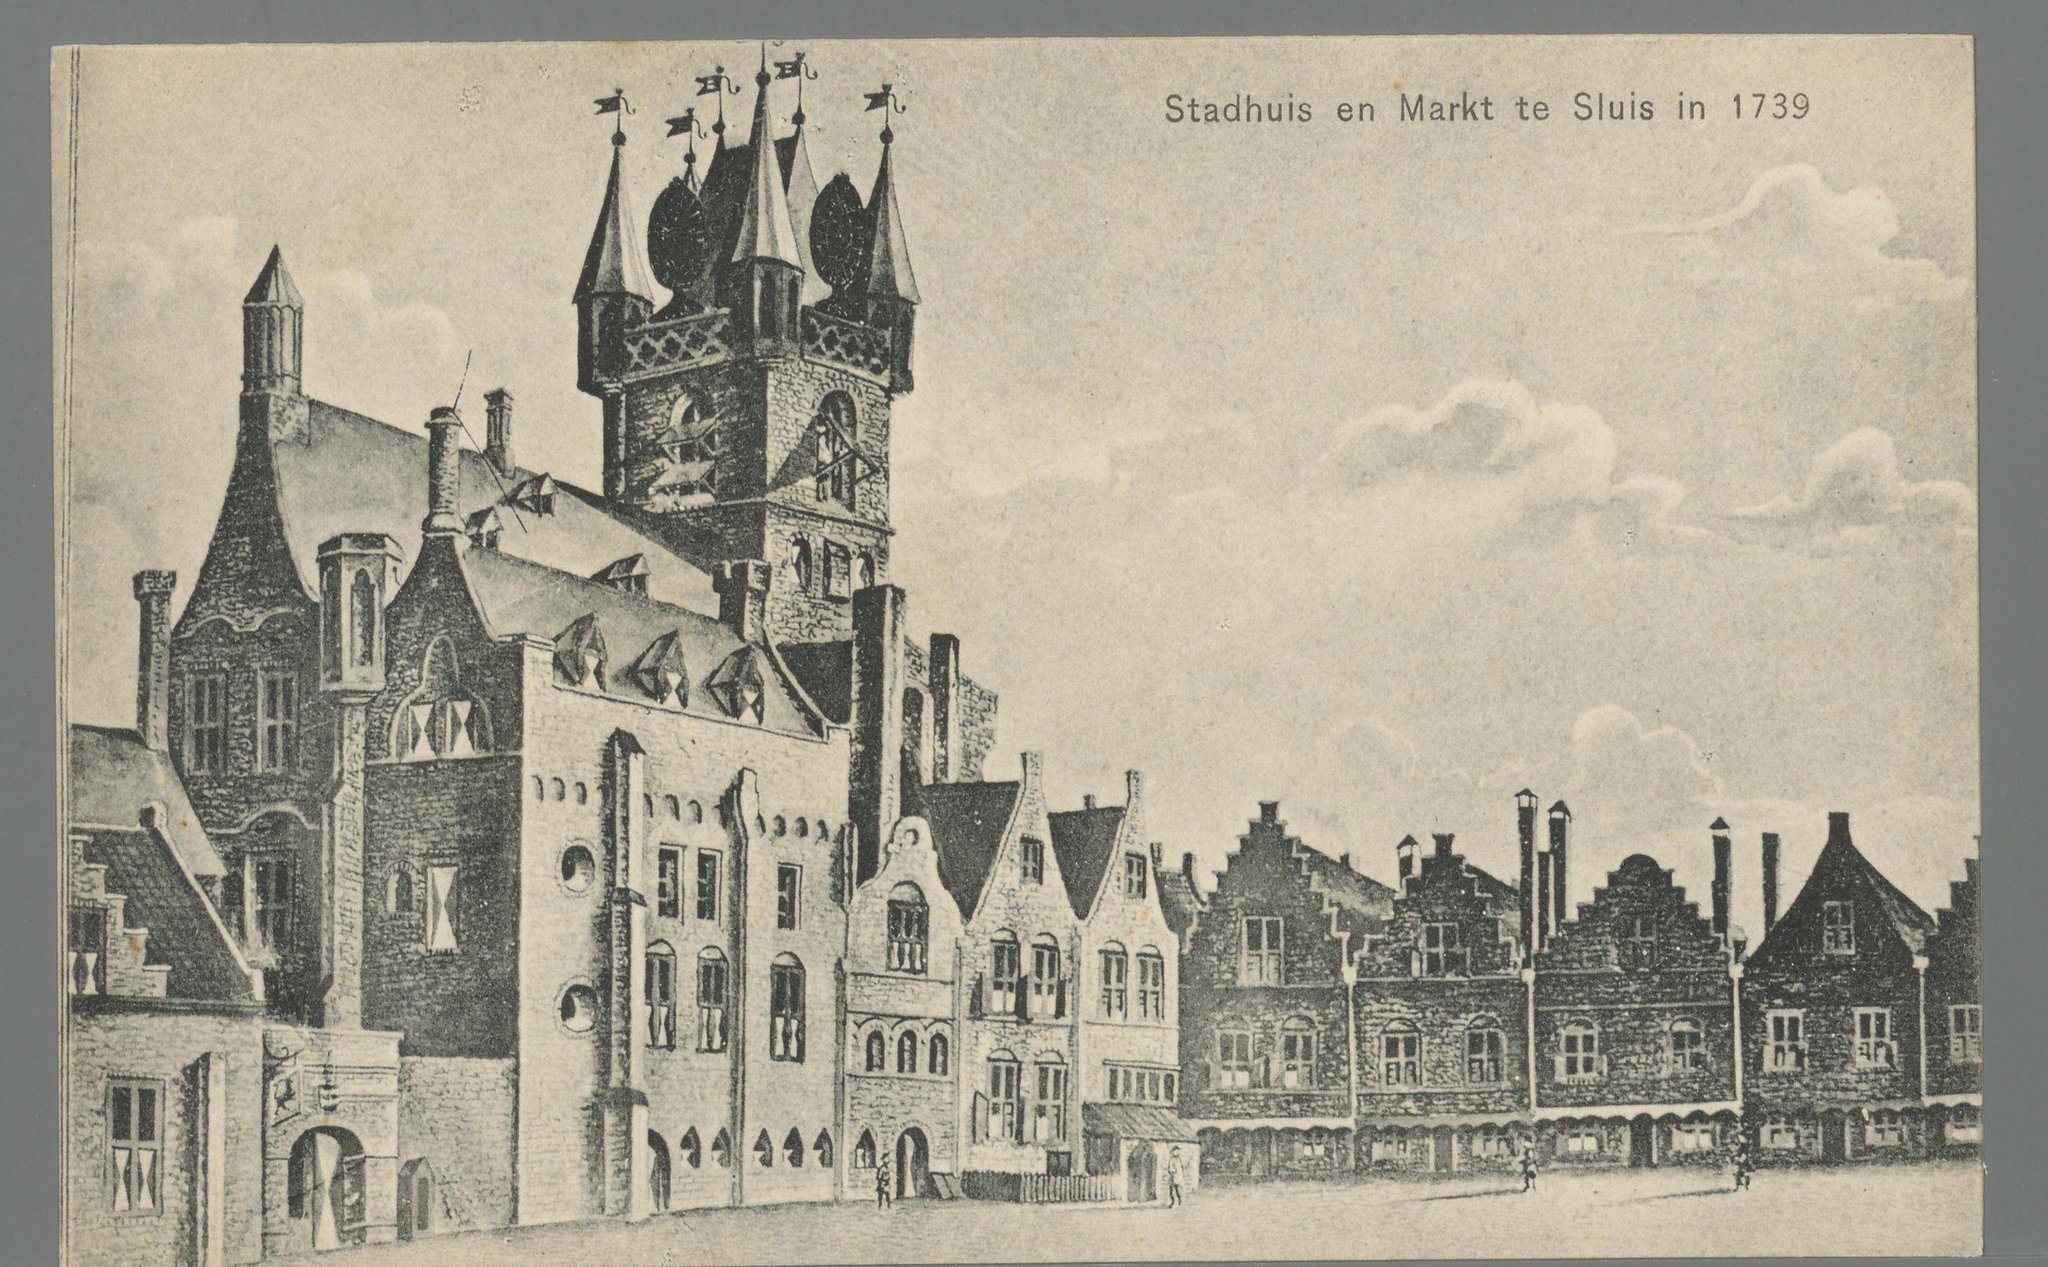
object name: ansichtkaart, prentbriefkaart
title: Stadhuis en Markt te Sluis in 1739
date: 1909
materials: cardboard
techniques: photograph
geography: sluis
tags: square, place, circus, etc., townhall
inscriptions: date